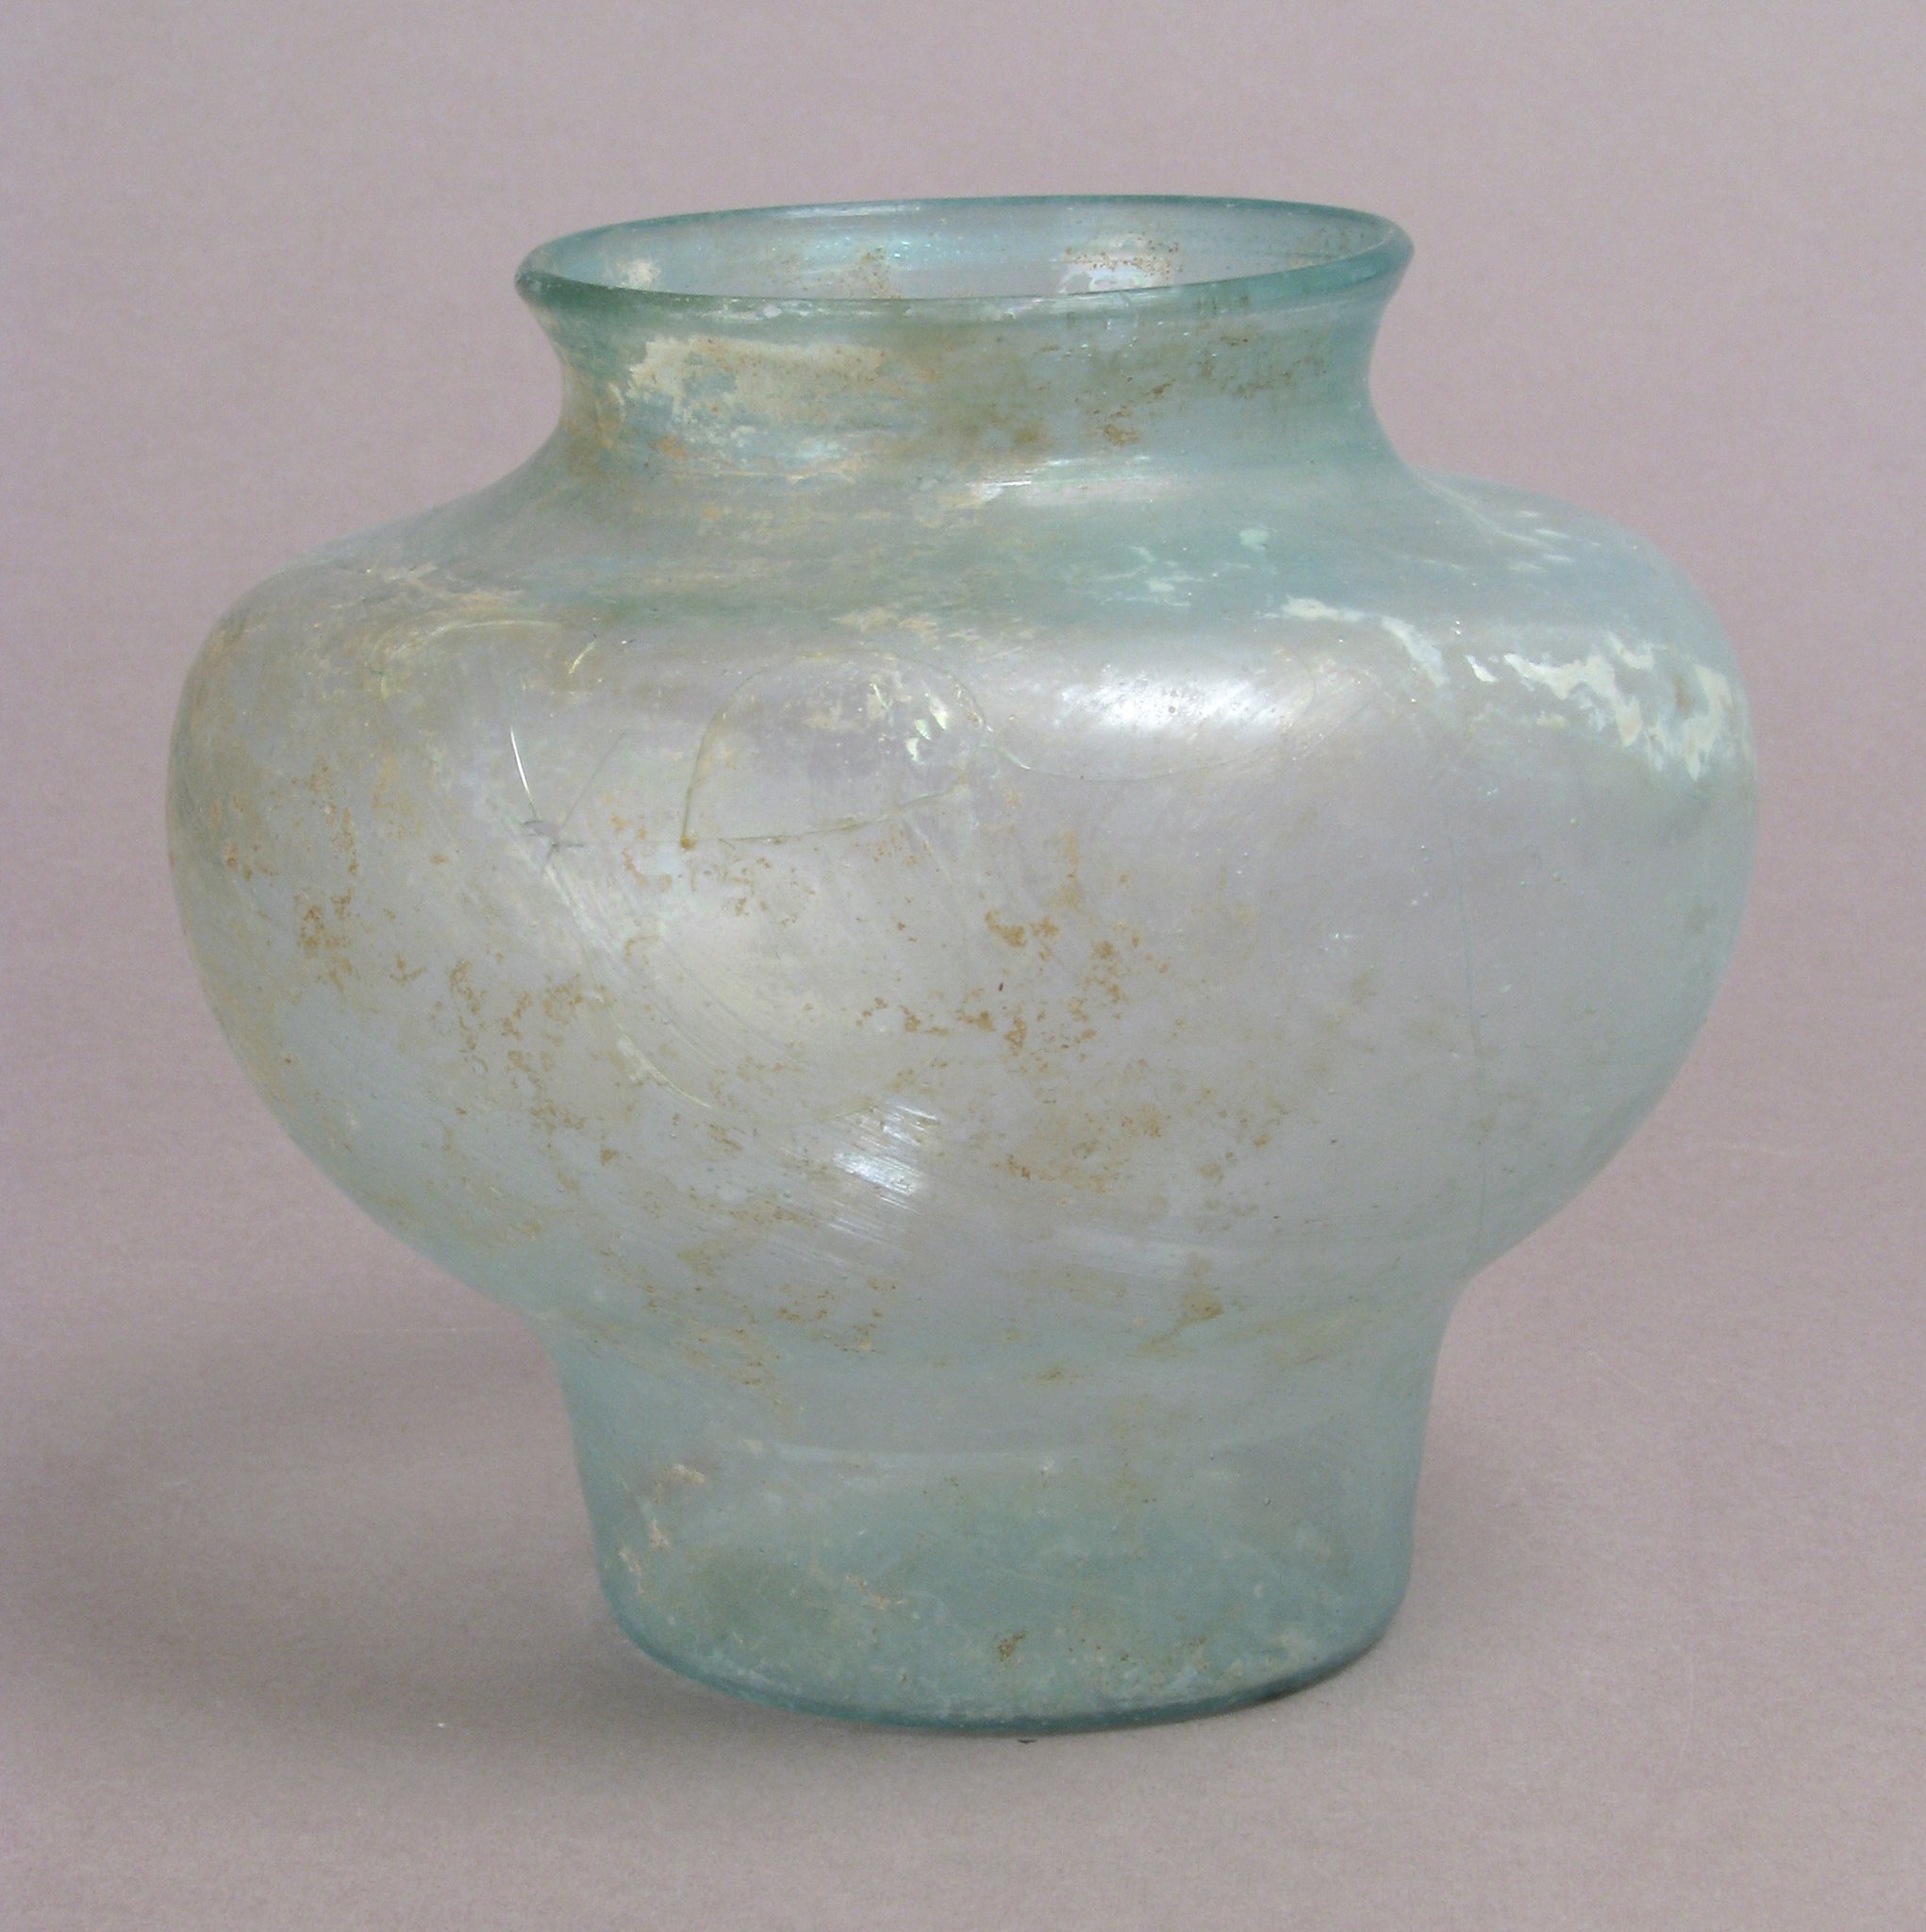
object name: jar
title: Globular Jar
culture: frankish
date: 367-433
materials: glass